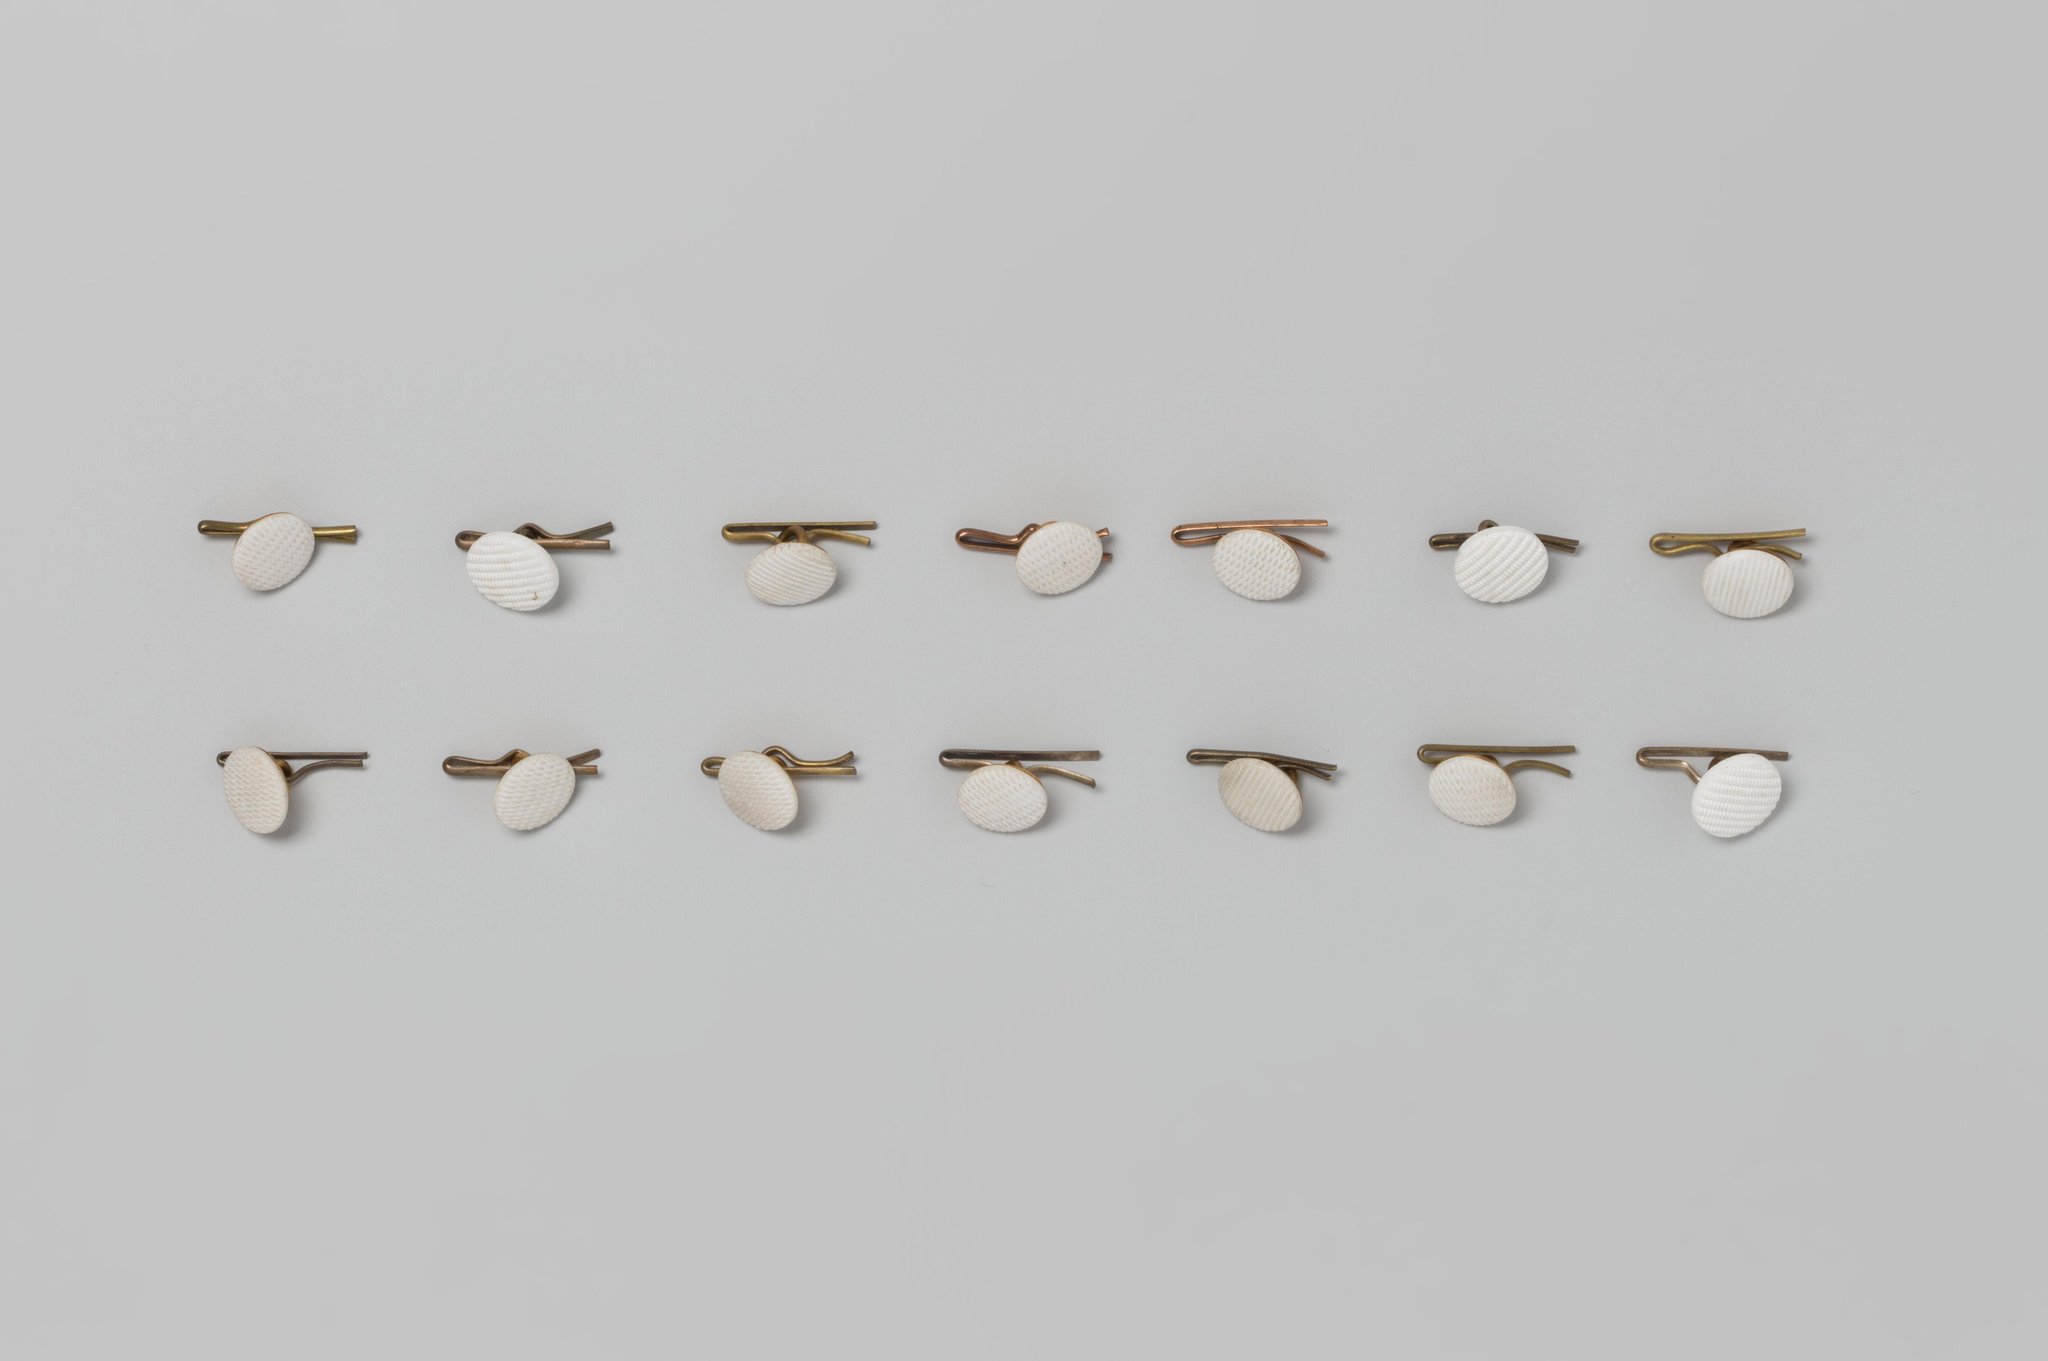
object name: vestknoop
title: Vestknoop van kunststof met reliëf-ribbel met vast oogje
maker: Anonymous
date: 1900-1940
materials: copper, plastic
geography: netherlands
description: Vestknoop van kunststof met reliëf-ribbel met vast oogje.